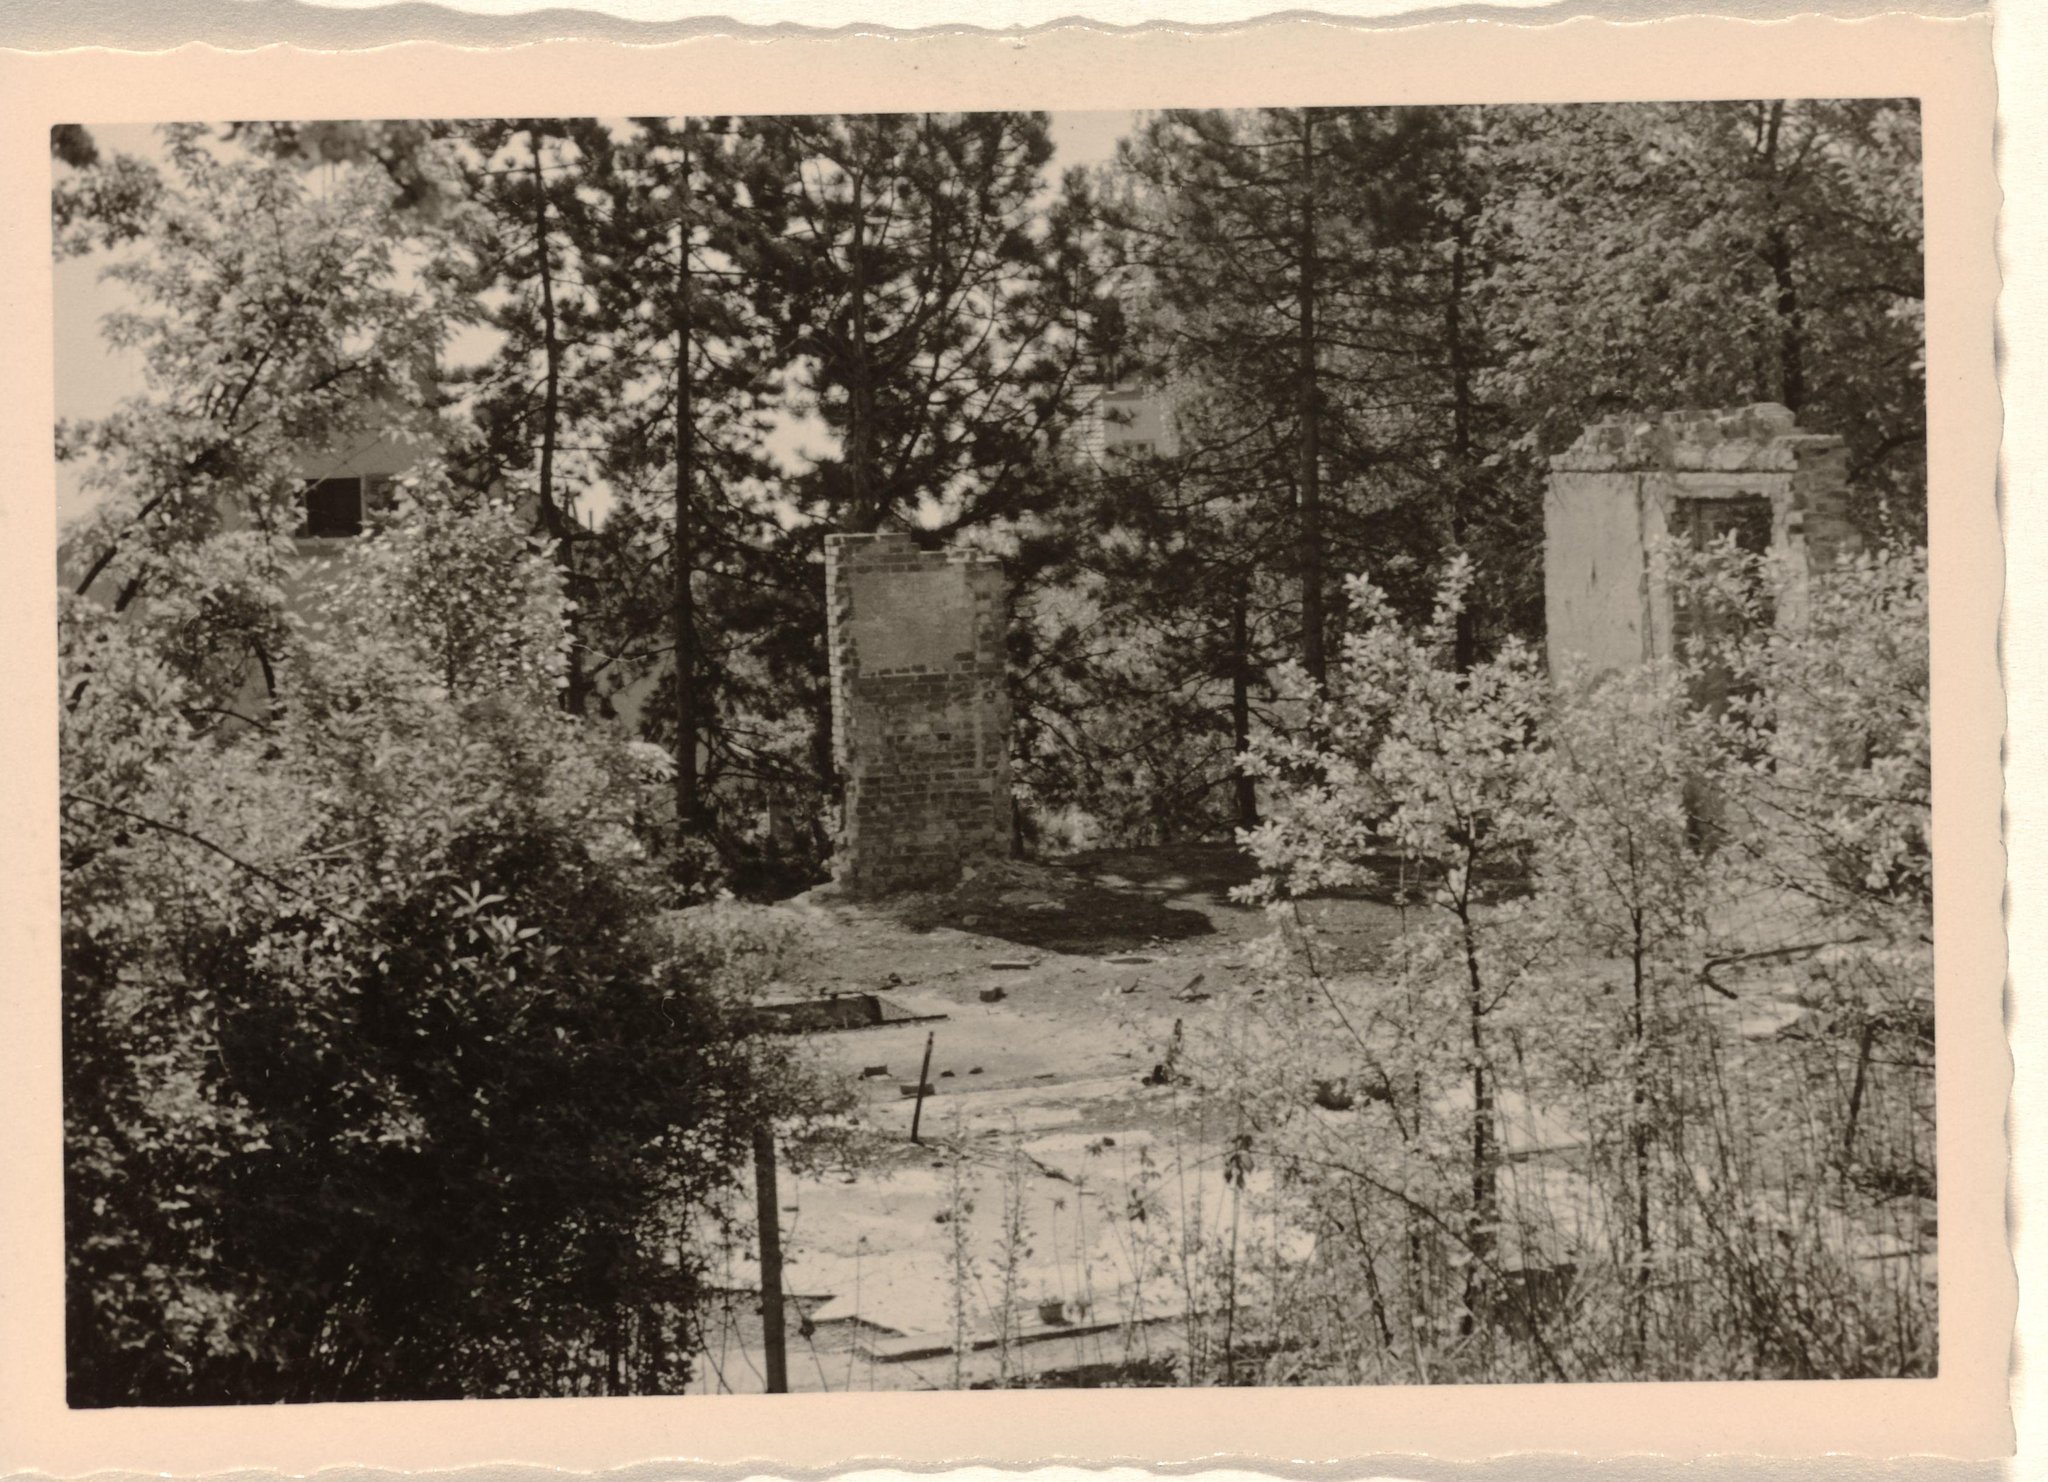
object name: photograph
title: Deel van een ruïne, met daar omheen stevige begroeing van bomen en struiken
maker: Anonymous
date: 1945-1970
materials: photographic support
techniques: gelatin silver print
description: Deel van een ruïne, met daar omheen stevige begroeing van bomen en struiken.